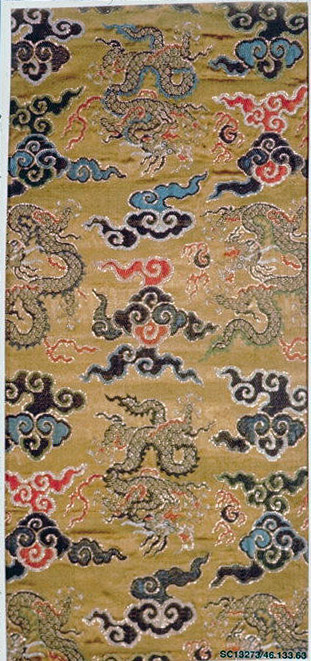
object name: piece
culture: chinese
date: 1667-1733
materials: metal thread, silk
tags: dragons,clouds